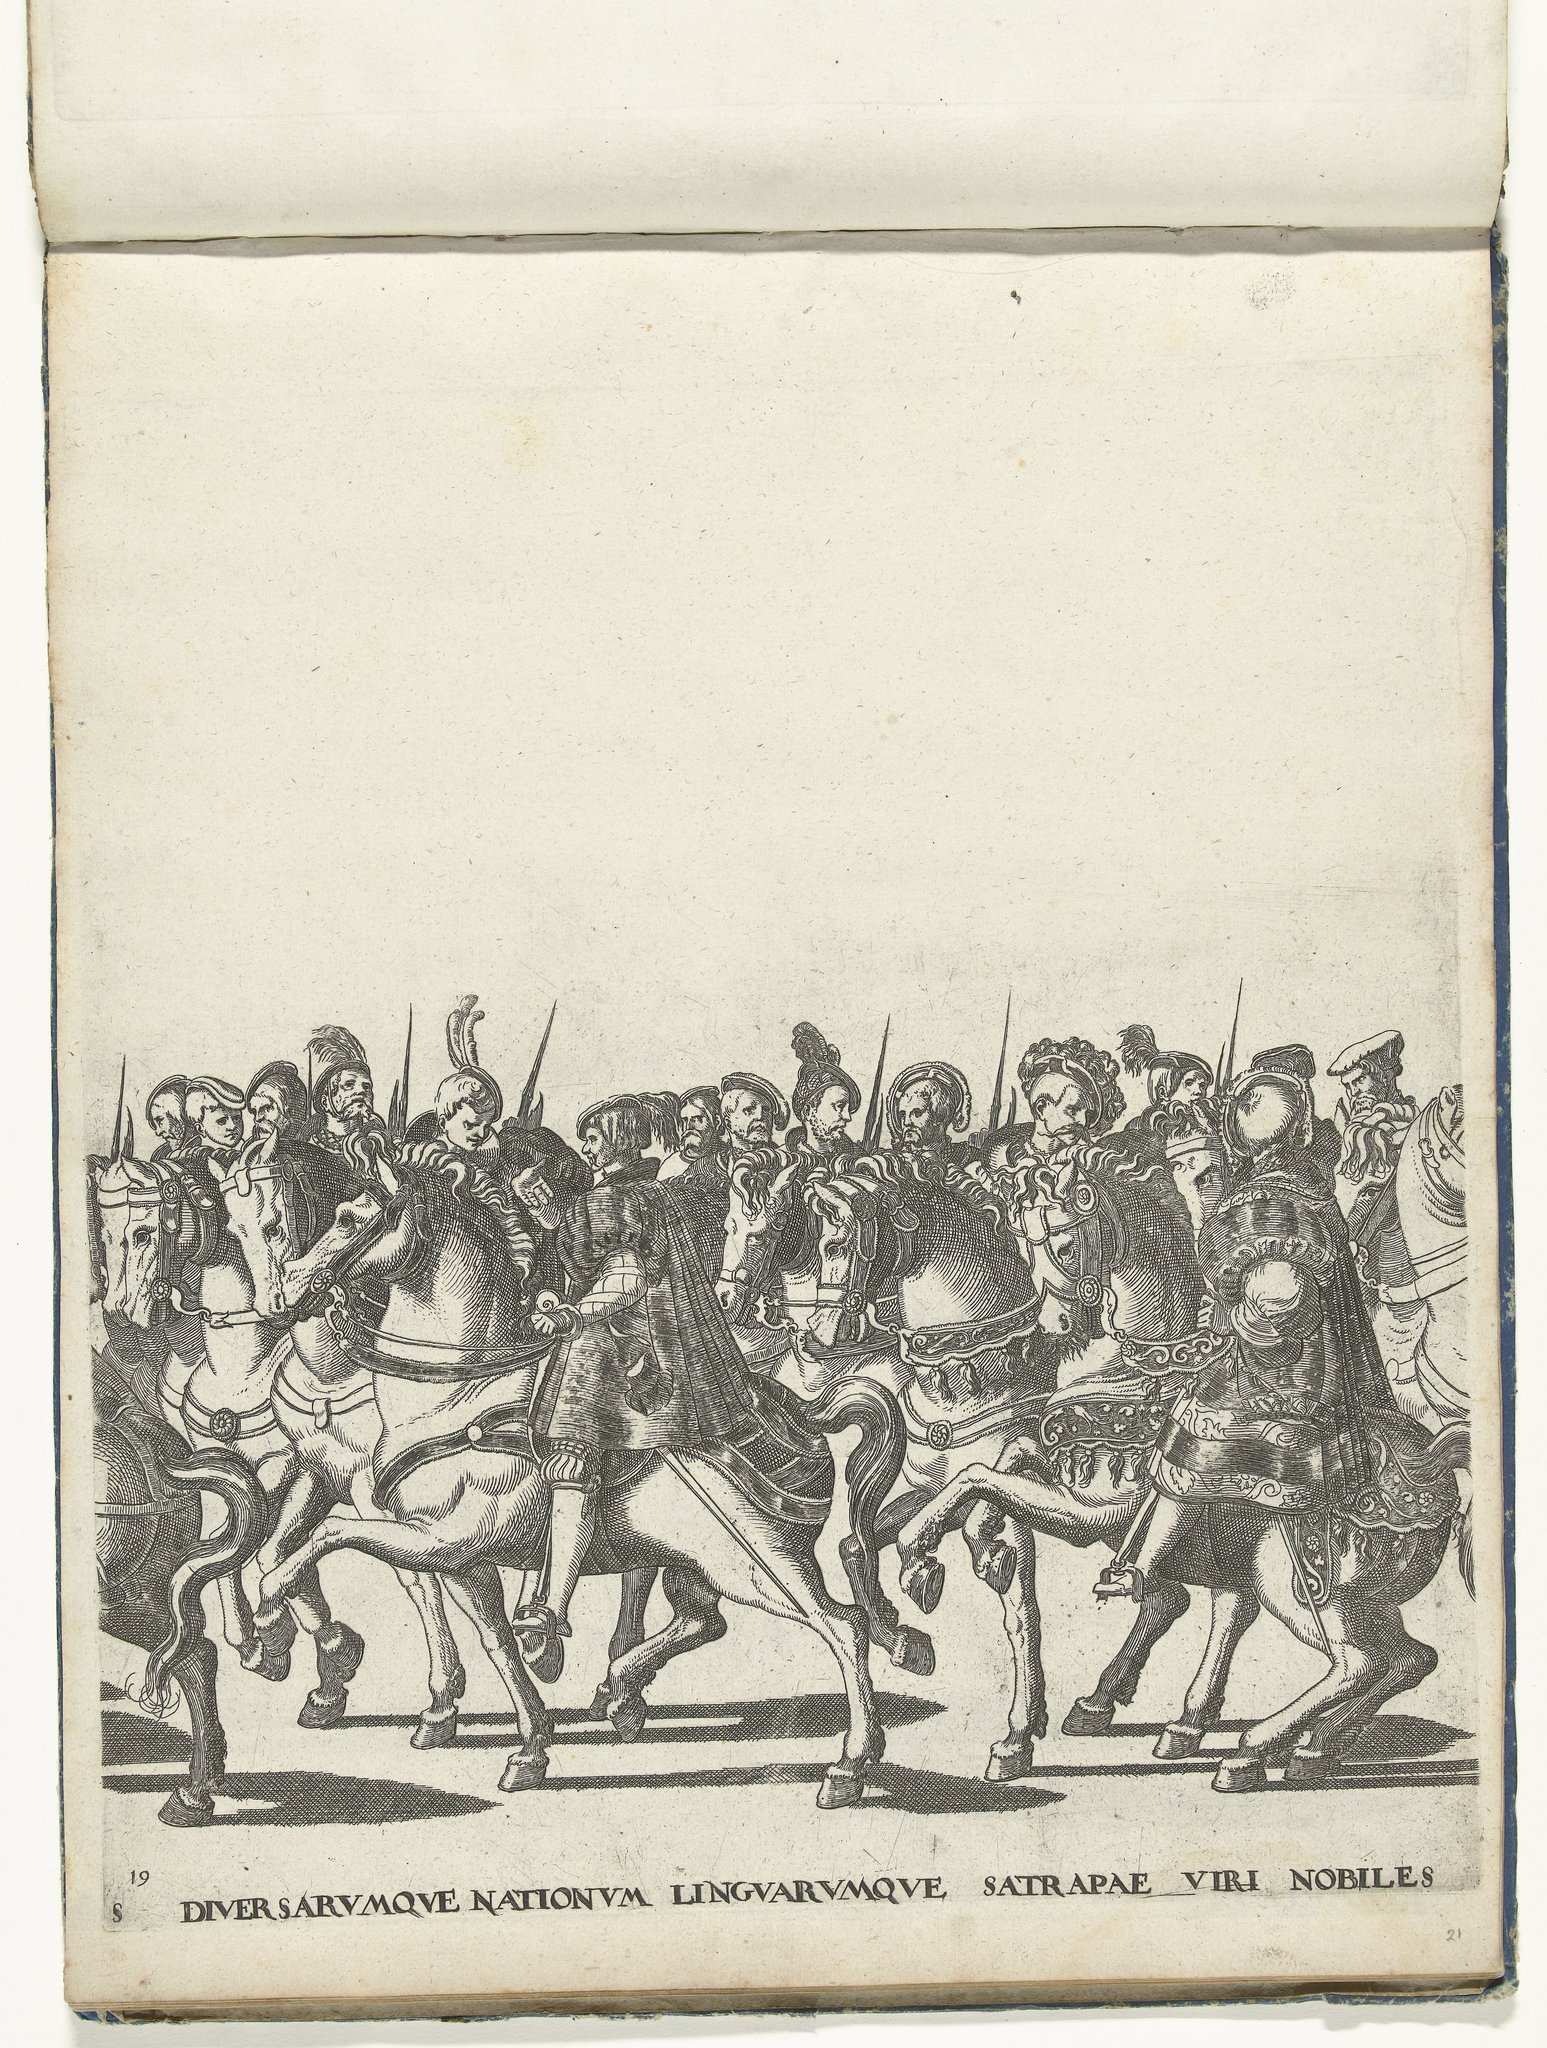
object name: album leaf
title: Diverse edelen, plaat 19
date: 1530-1536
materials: paper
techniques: engraving, etching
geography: the hague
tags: ghent, charles v (holy roman emperor and king of spain), festivities (+ parade, pageant, cavalcade ~ festive activities)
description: Prent in het album waarin zijn ingeplakt de 40 platen die achterelkaar samen het fries vormen van de optocht van Karel V met de paus Clemens VII te Bologna na zijn kroning tot keizer, 24 februari 1530.